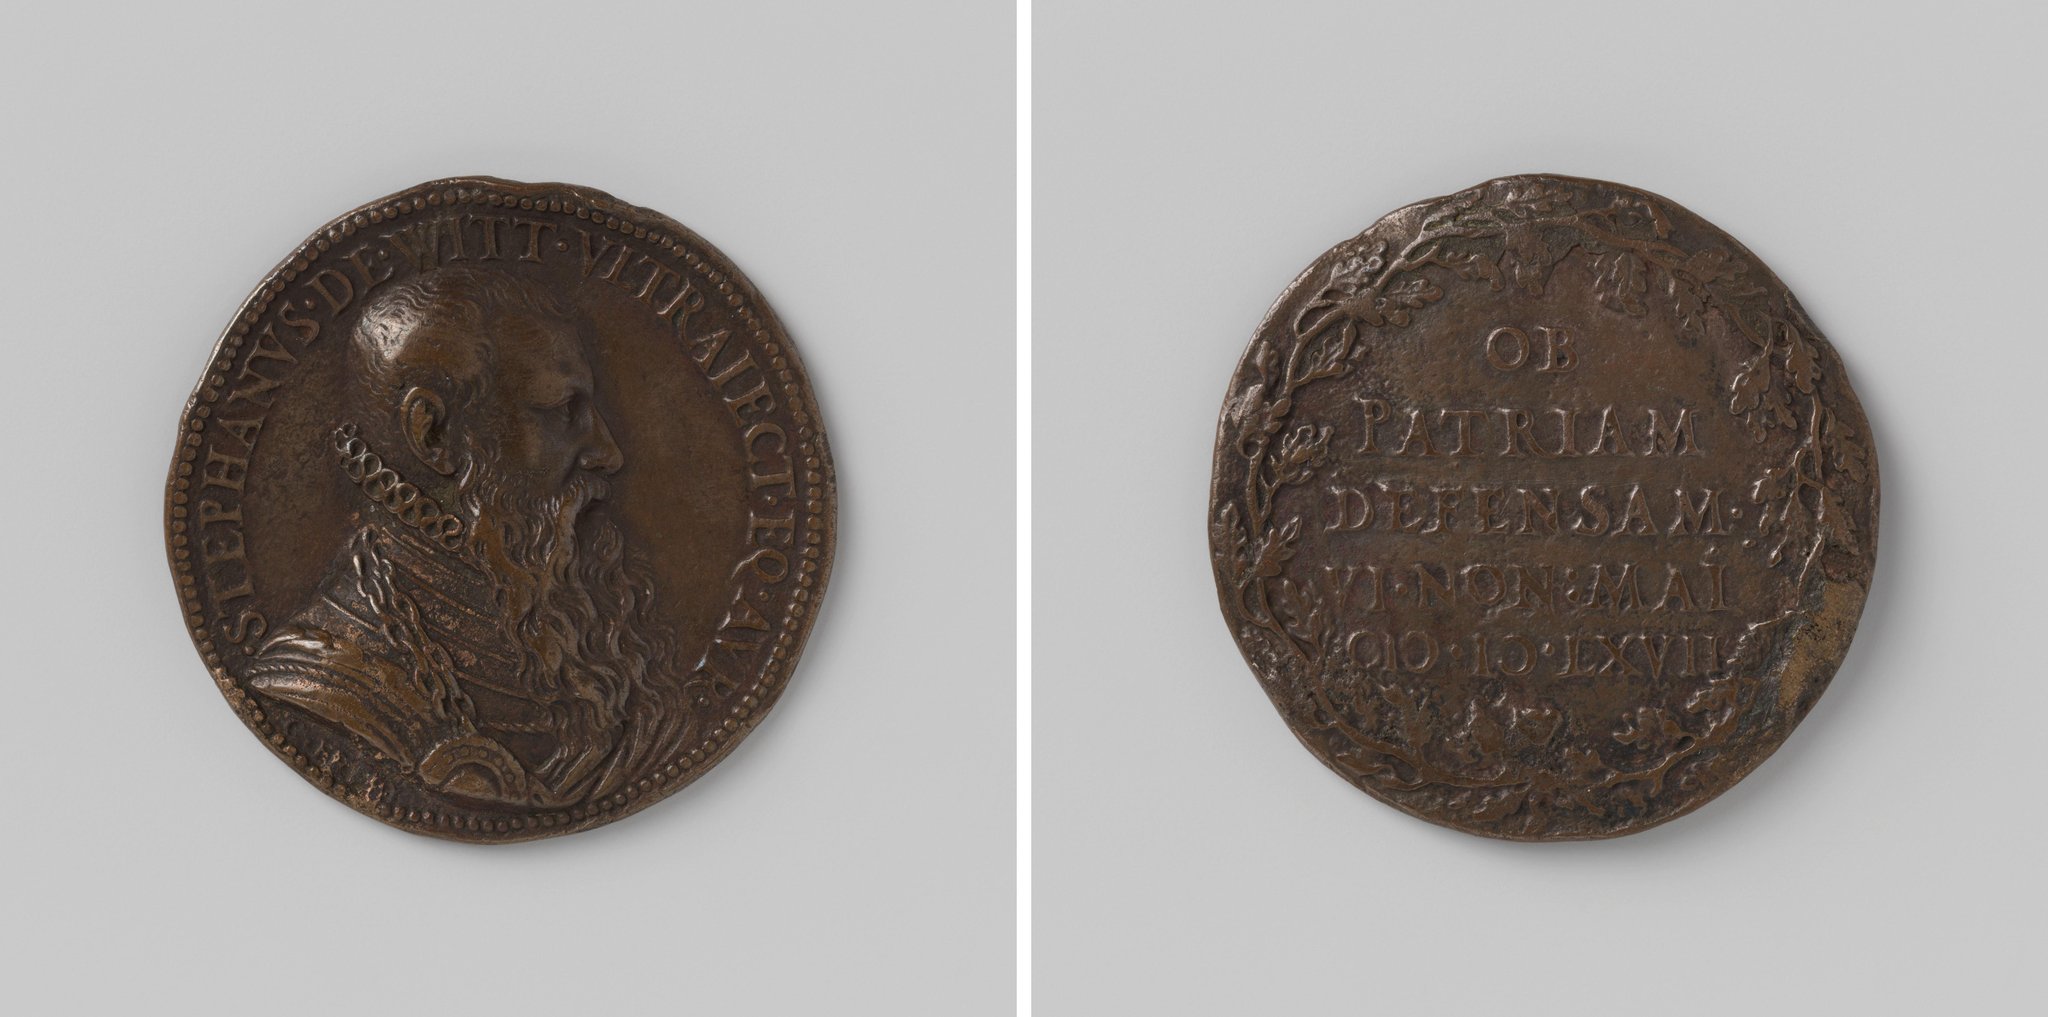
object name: jeton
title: Steven de Witt uit Utrecht verslaat de troepen van Brederode onder leiding van Jan van Renesse bij de schans van Vreeswijk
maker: claude frémy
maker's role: medailleur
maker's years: 1620-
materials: bronze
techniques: casting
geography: belgium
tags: utrecht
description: Bronzen penning. Voorzijde: borststuk man binnen omschrift. Keerzijde: opschrift binnen bladerkrans.